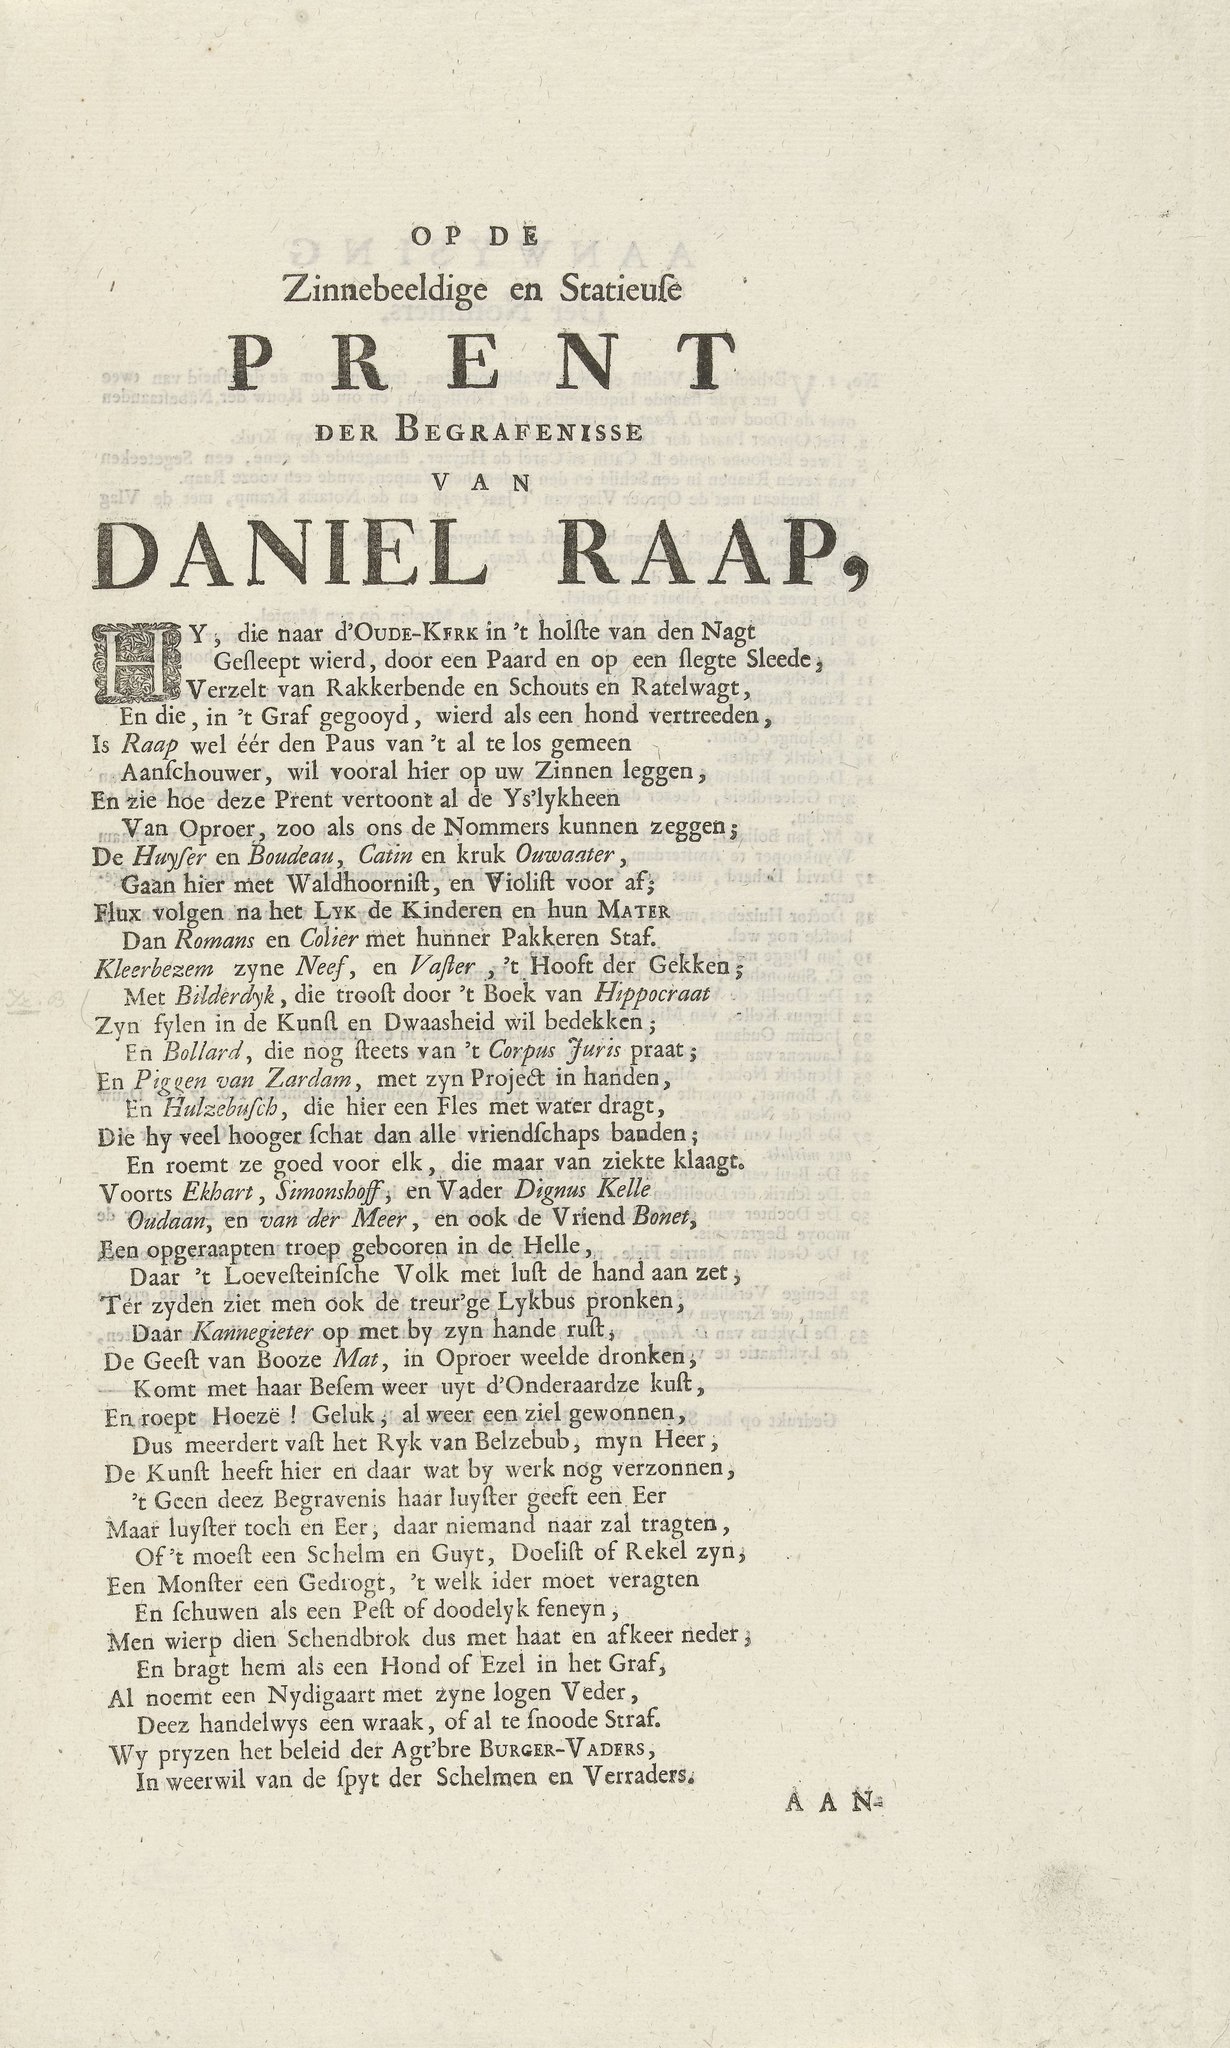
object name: text sheet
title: Tekstblad bij de spotprent op de begrafenis van Daniël Raap, 1754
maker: Anonymous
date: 1754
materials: paper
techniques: letterpress printing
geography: northern netherlands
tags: handelaar, daniël raap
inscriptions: collector's mark: Lugt 2228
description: tekstblad behorend bij de spotprent op de begrafenis van de koopman en Orangist Daniël Raap op 15 januari 1754 te Amsteredam. Op de voorzijde een vers, op de achterzijde een verklaring van de nummers 1-33 in de voorstelling.